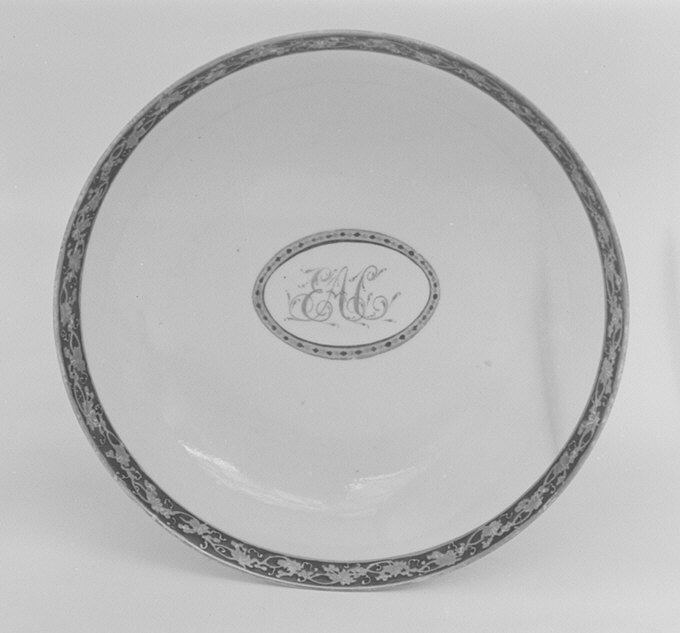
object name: saucer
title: Saucer (part of a service)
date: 1790-1800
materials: hard paste porcelain